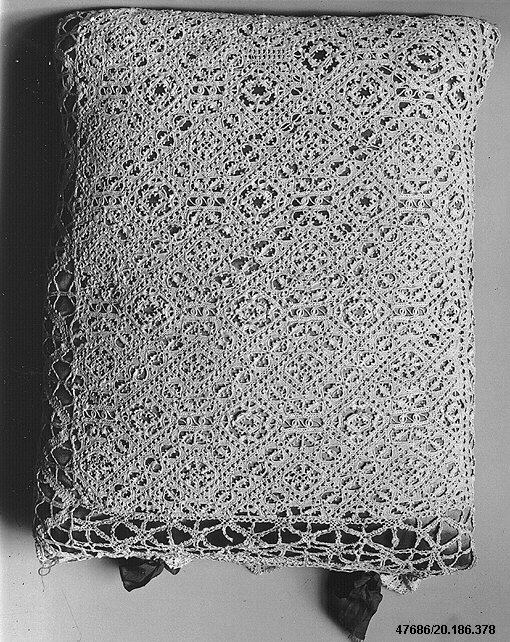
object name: pillowcase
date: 1601-1633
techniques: lace, embroidery